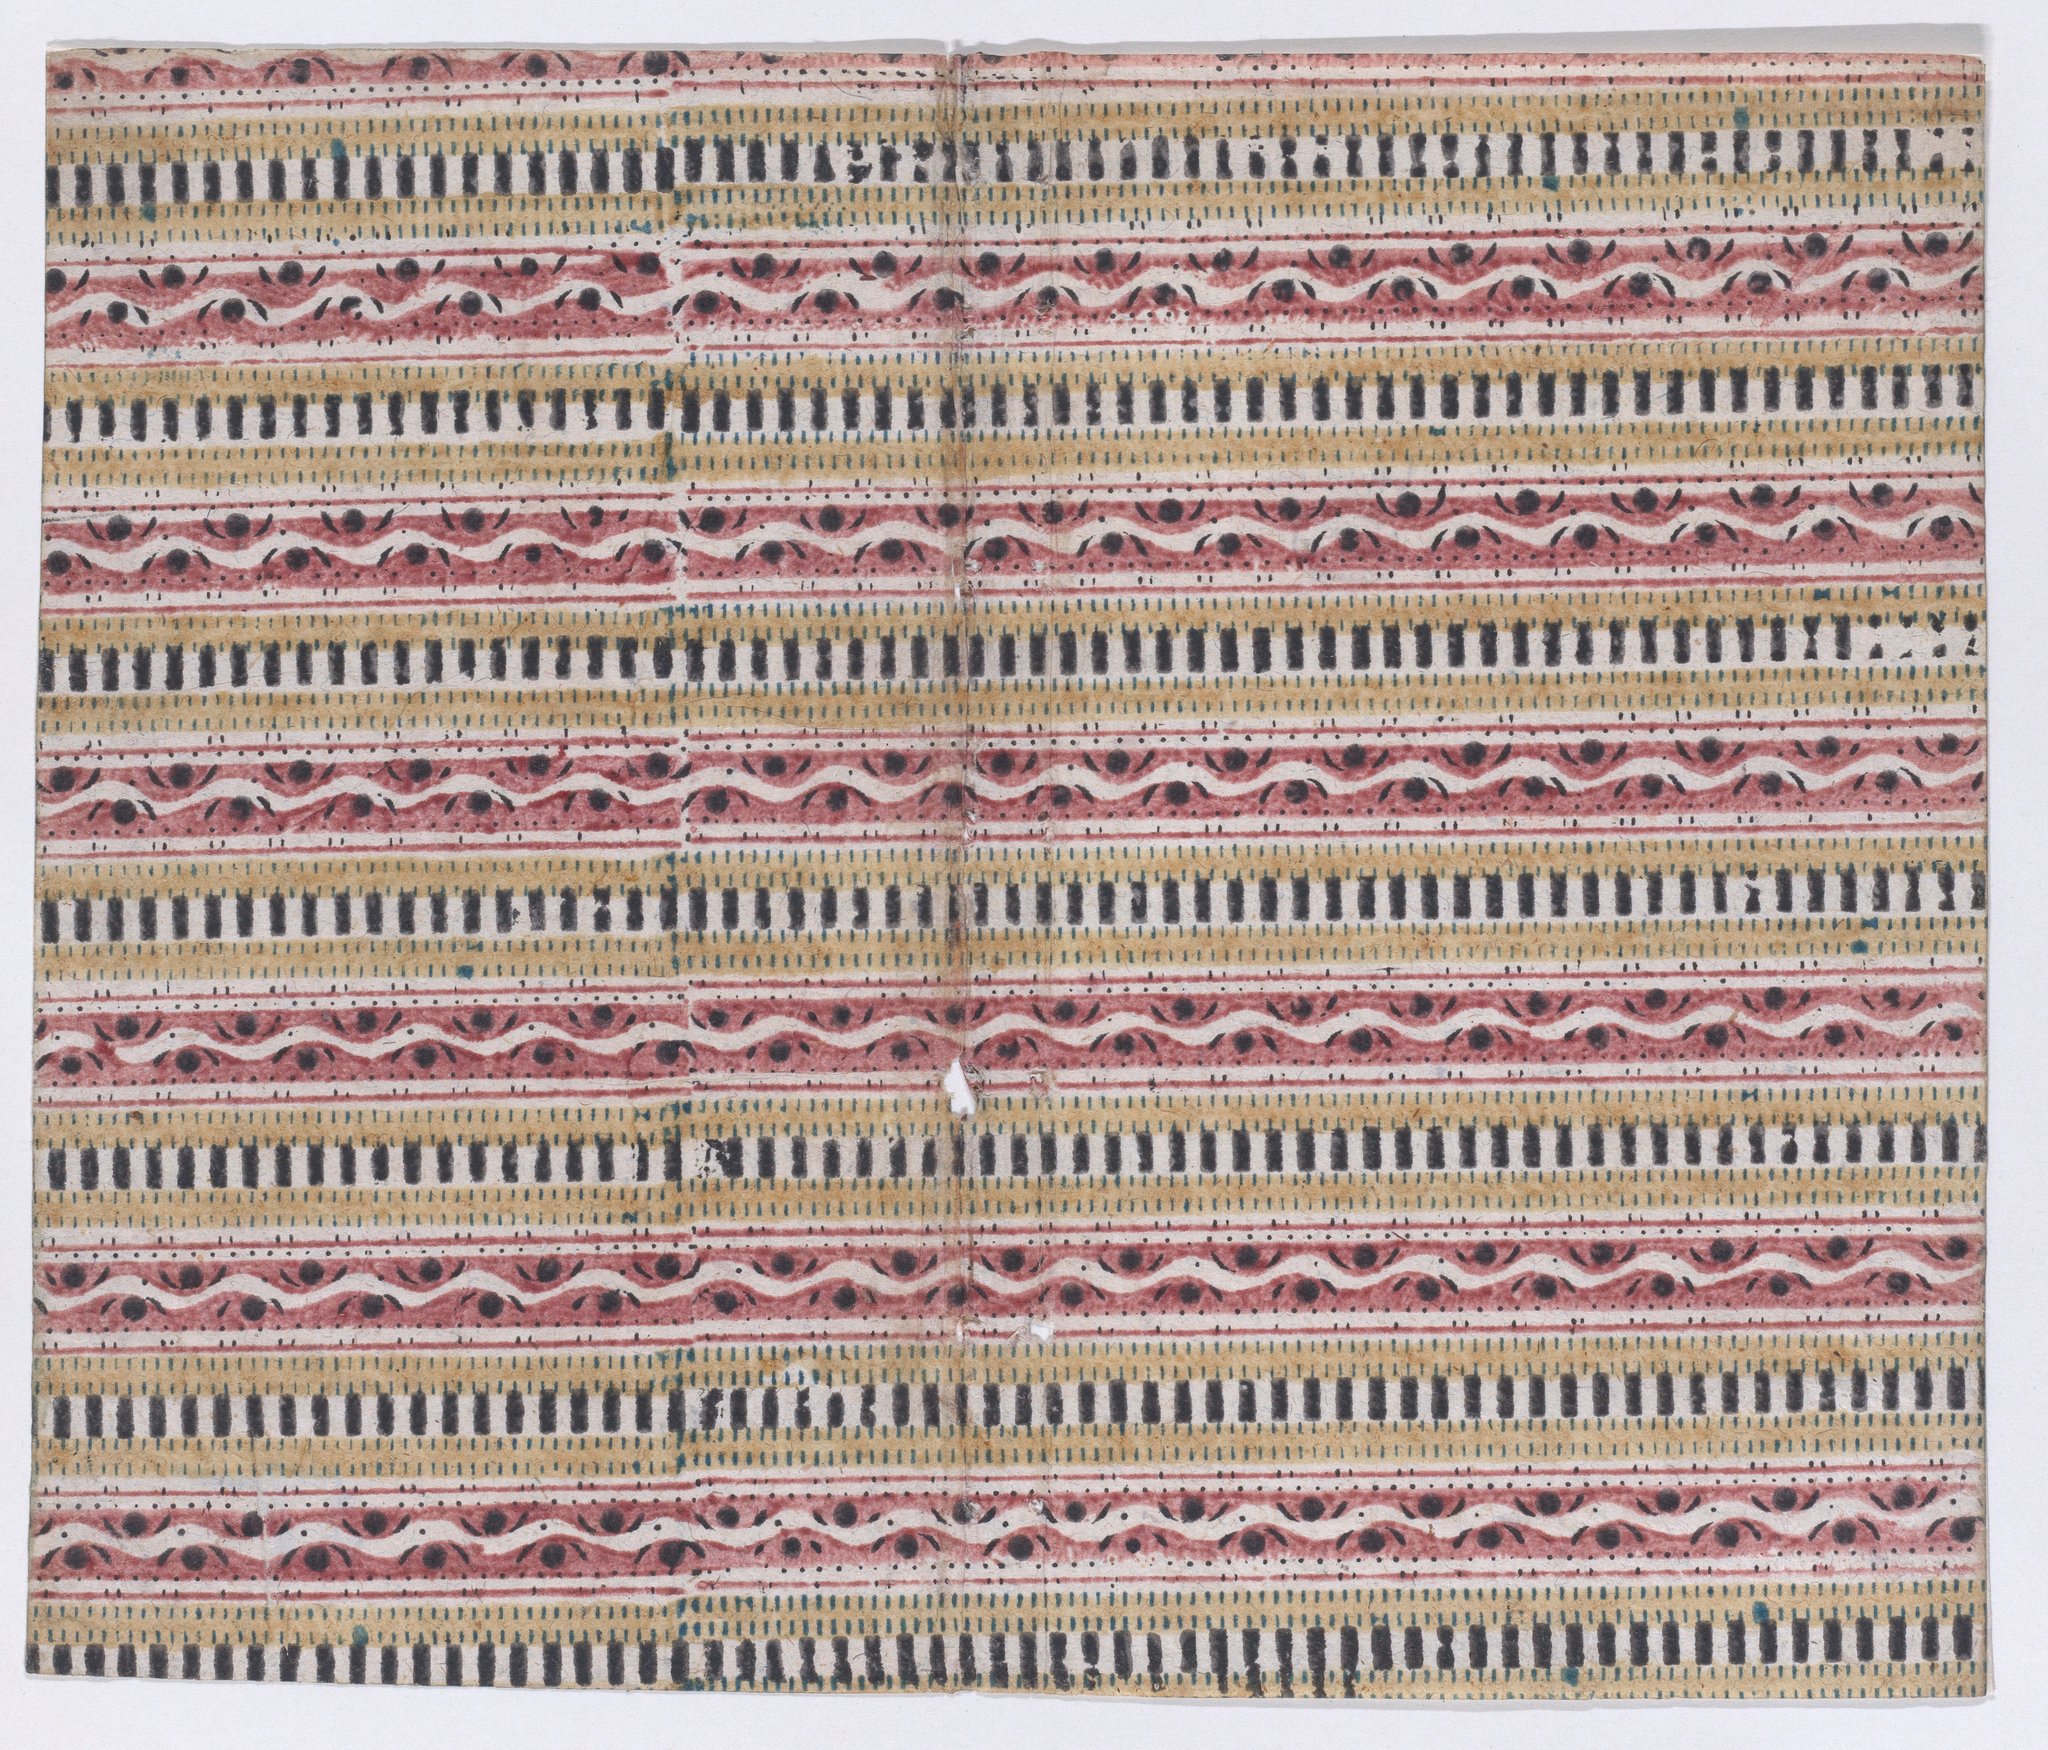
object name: print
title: Book cover with overall geometric and stripe pattern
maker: Anonymous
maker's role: artist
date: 1801-1900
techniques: relief print